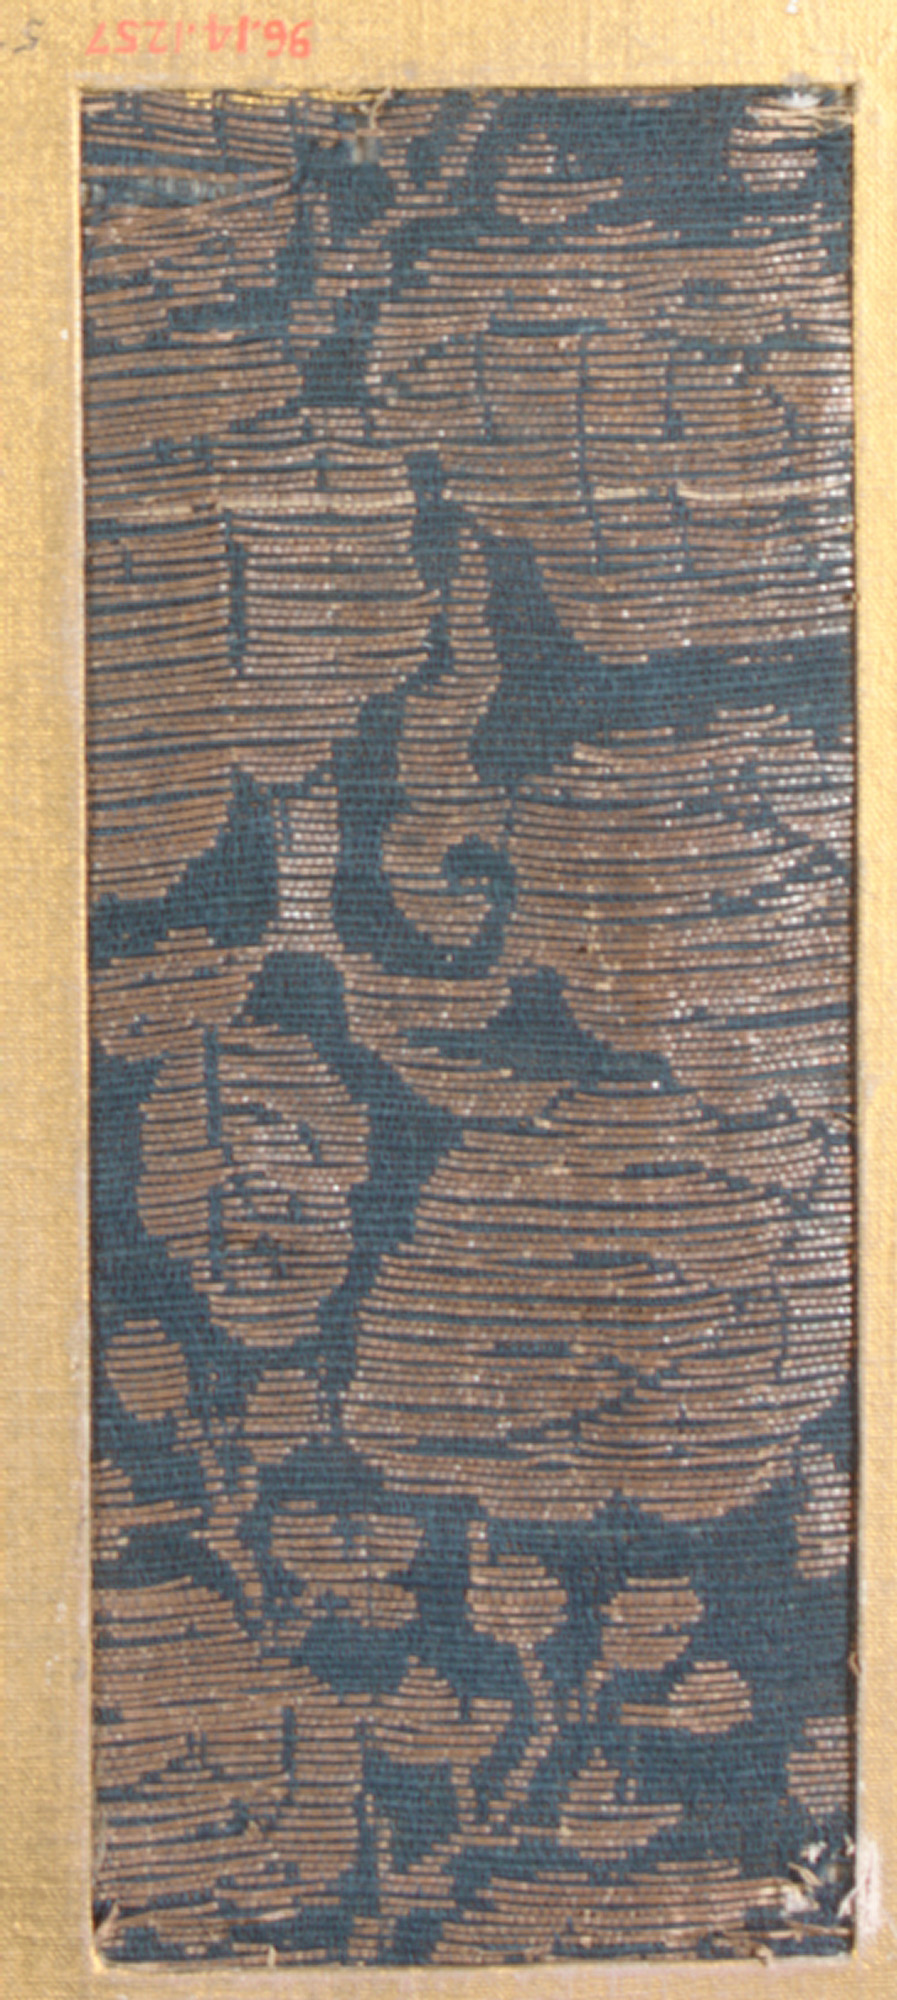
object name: piece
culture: japanese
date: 1701-1900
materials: silk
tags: flowers